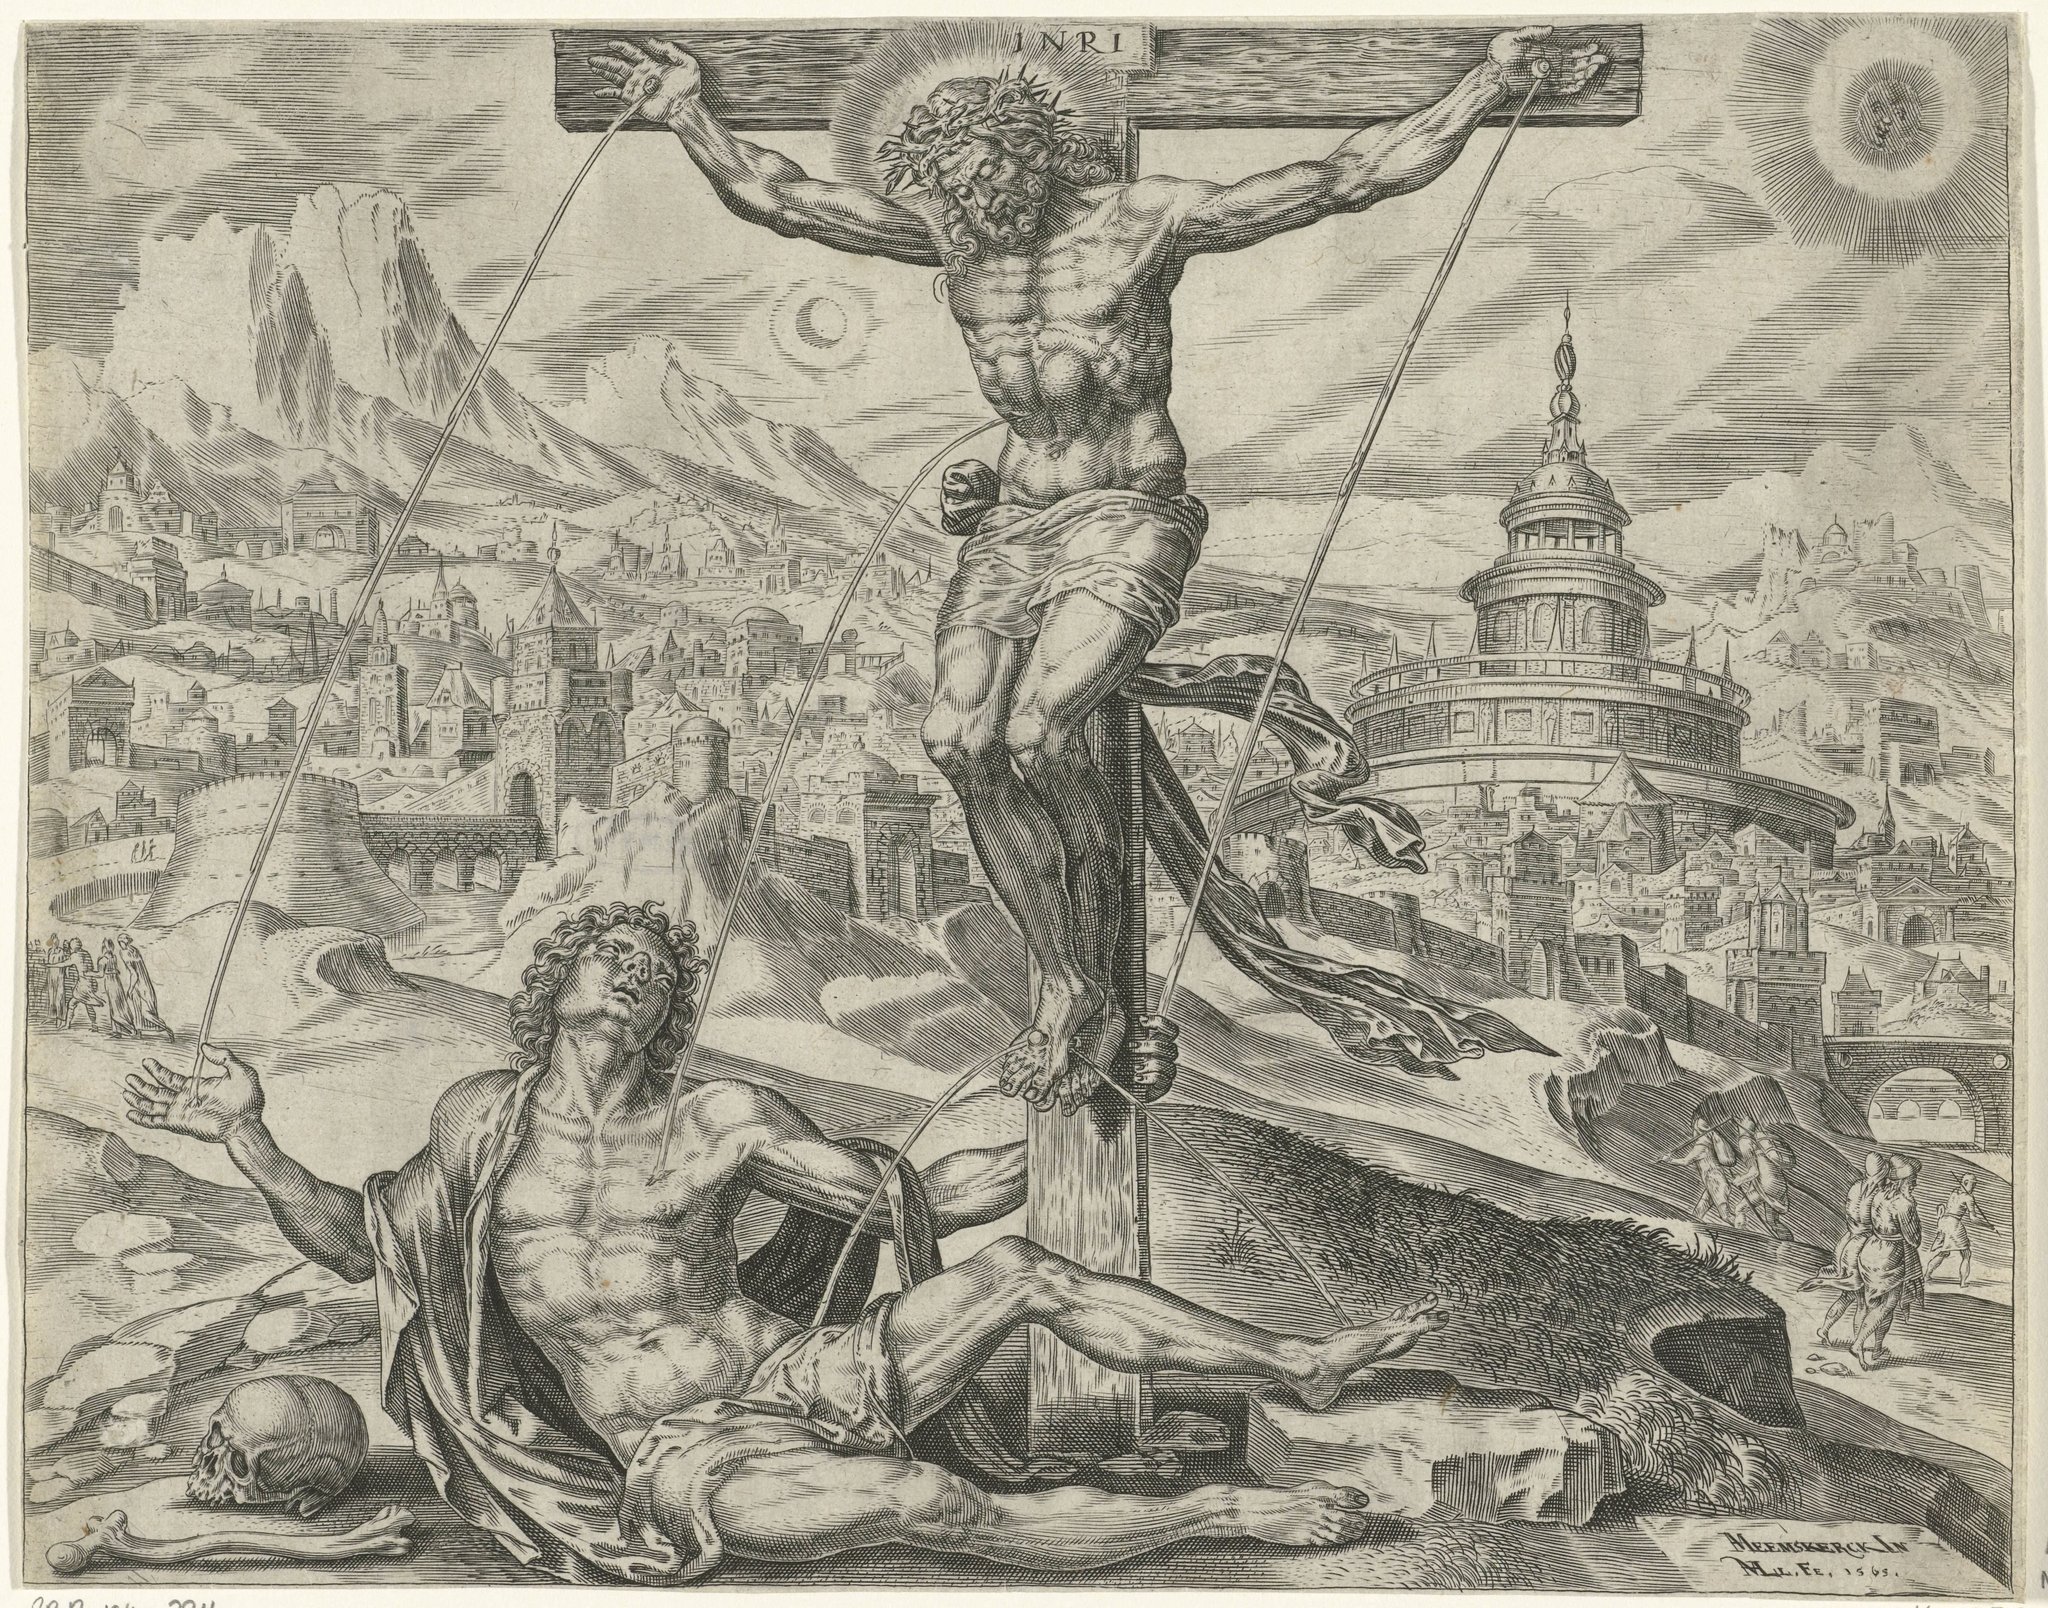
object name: print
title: Christus als de barmhartige Samaritaan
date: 1565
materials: paper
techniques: engraving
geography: amsterdam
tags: city-view, and landscape with man-made constructions, the good samaritan (luke 10:30-37) (+ variant), the crucifixion of christ: prelude to christ's death on the cross (matthew 27:34-44; mark 15:23-32; luke 23:33-43; john 19:18-24), christ on the cross (in a fountain), shedding his blood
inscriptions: collector's mark: Lugt 2228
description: De gewonde Mens wordt genezen door het bloed van Christus dat op hem valt, terwijl hij onder het kruis ligt. Op de achtergrond een stad. Onderaan in de marge een vers in het Latijn. Variant op de gelijkenis van de barmhartige Samaritaan.